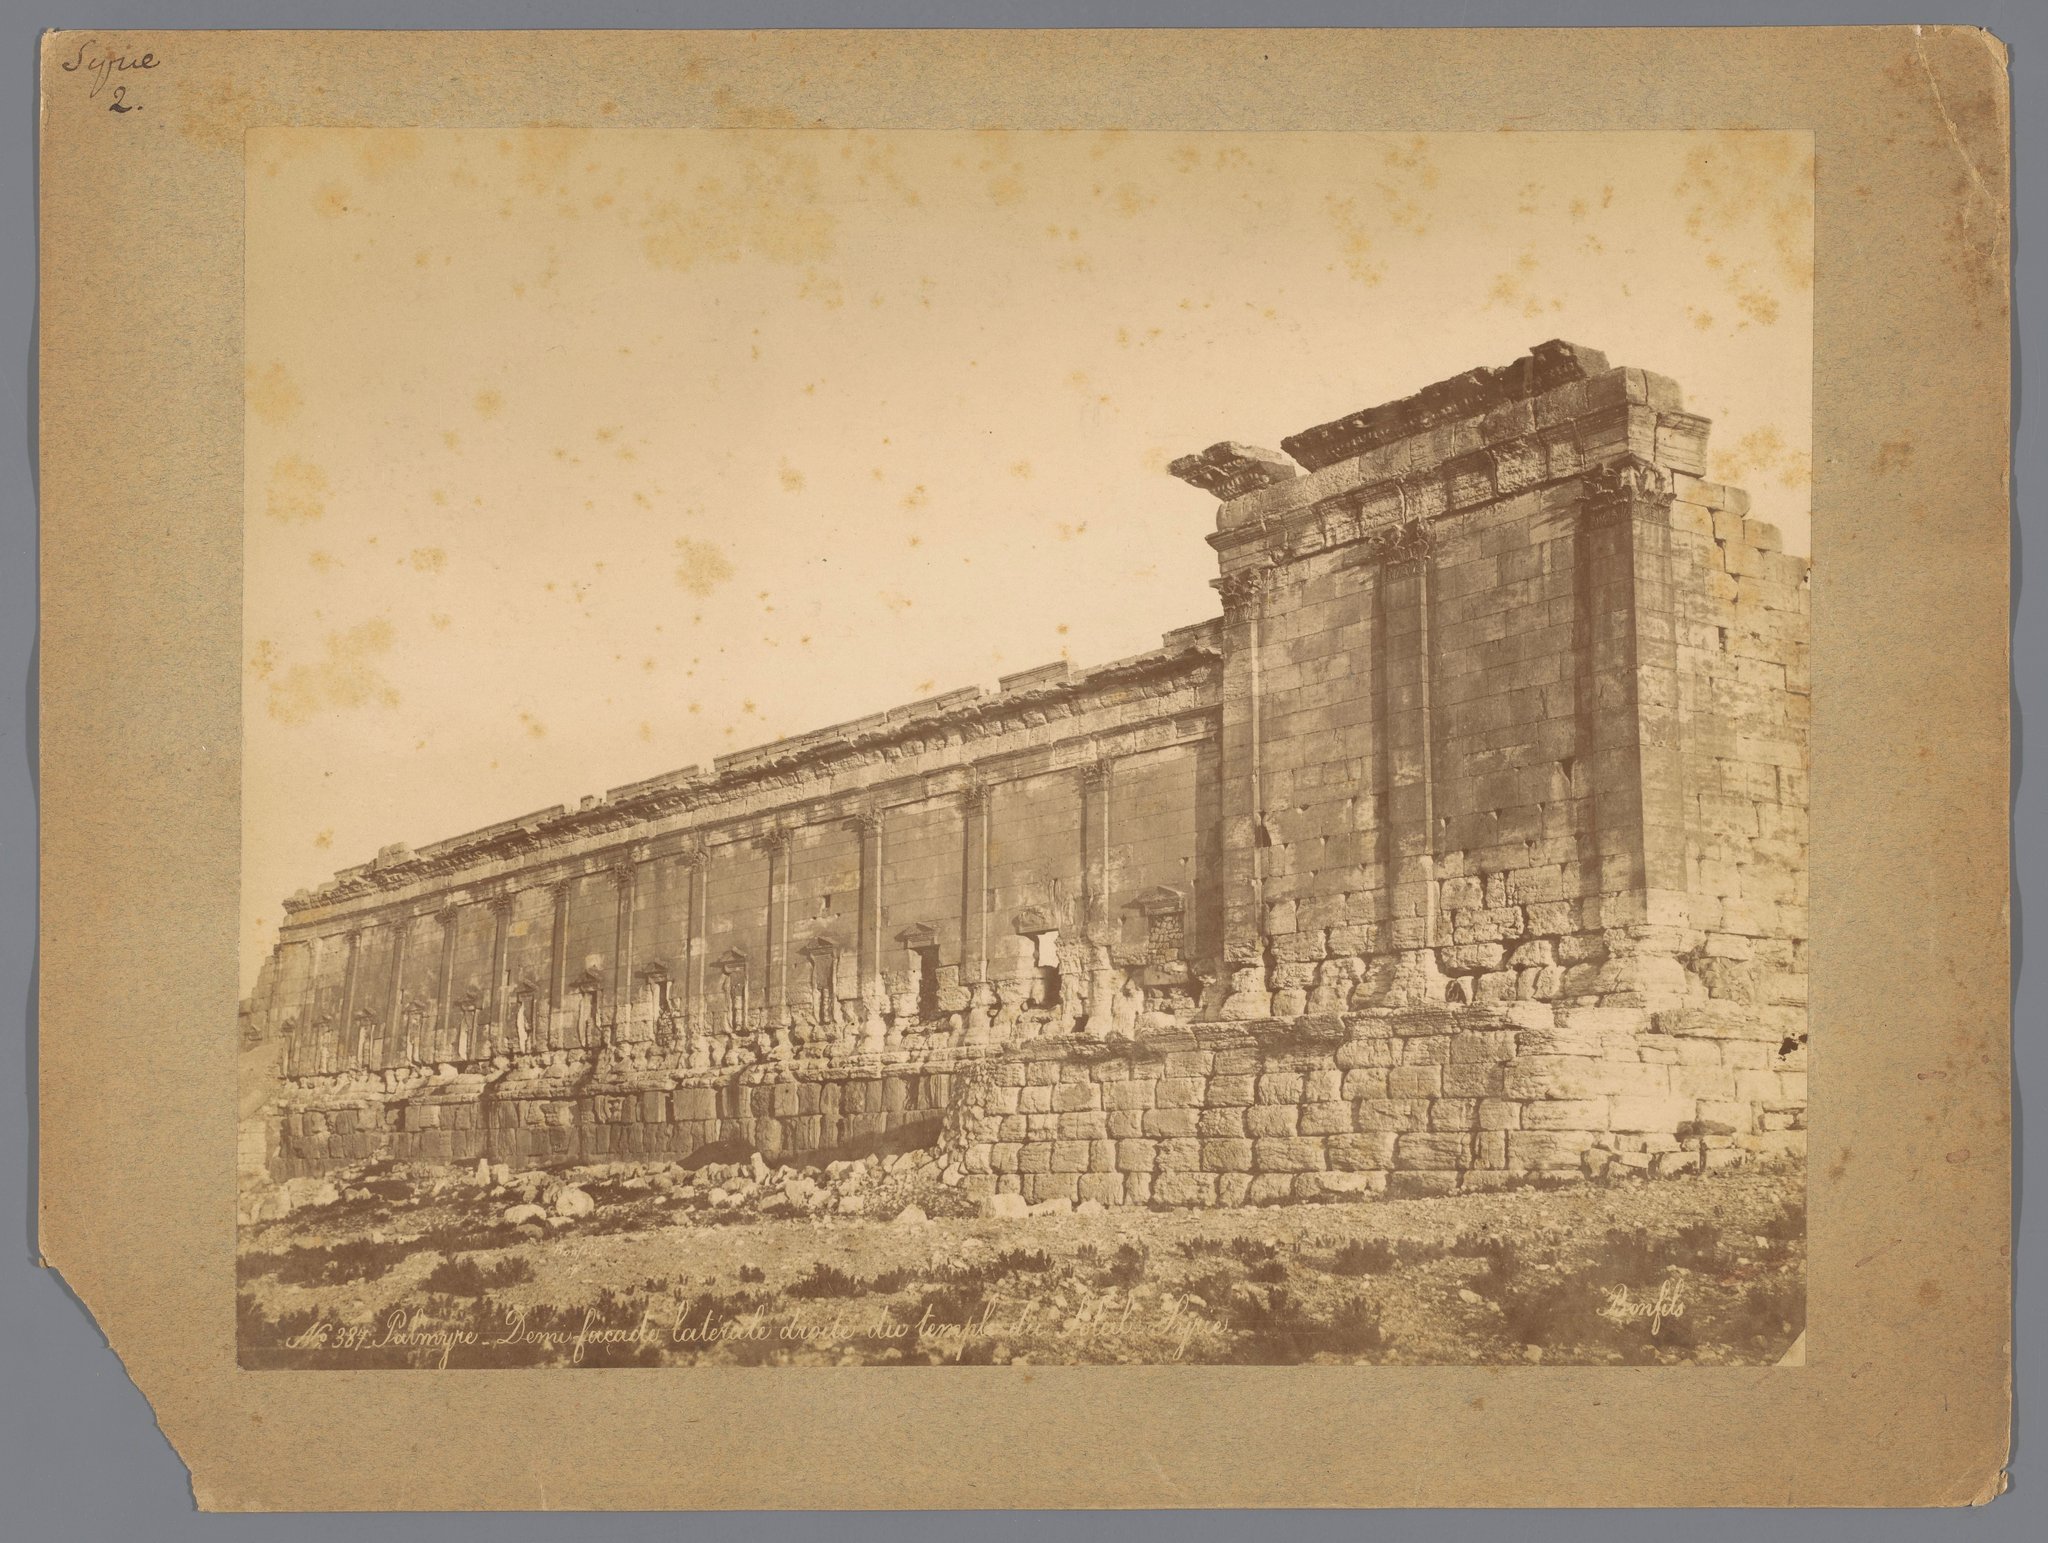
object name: photograph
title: Demi-façade latérale droite du temple du soleil, Syrie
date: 1850-1900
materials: cardboard, photographic support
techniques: albumen print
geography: palmyra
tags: temple, shrine ~ non-christian religions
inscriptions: collector's mark: ‘Rijks-normaalschool voor teekenonderwijzers Amsterdam’ Lugt 3937, number: ‘Syrie 2’, number: ‘No. 387’